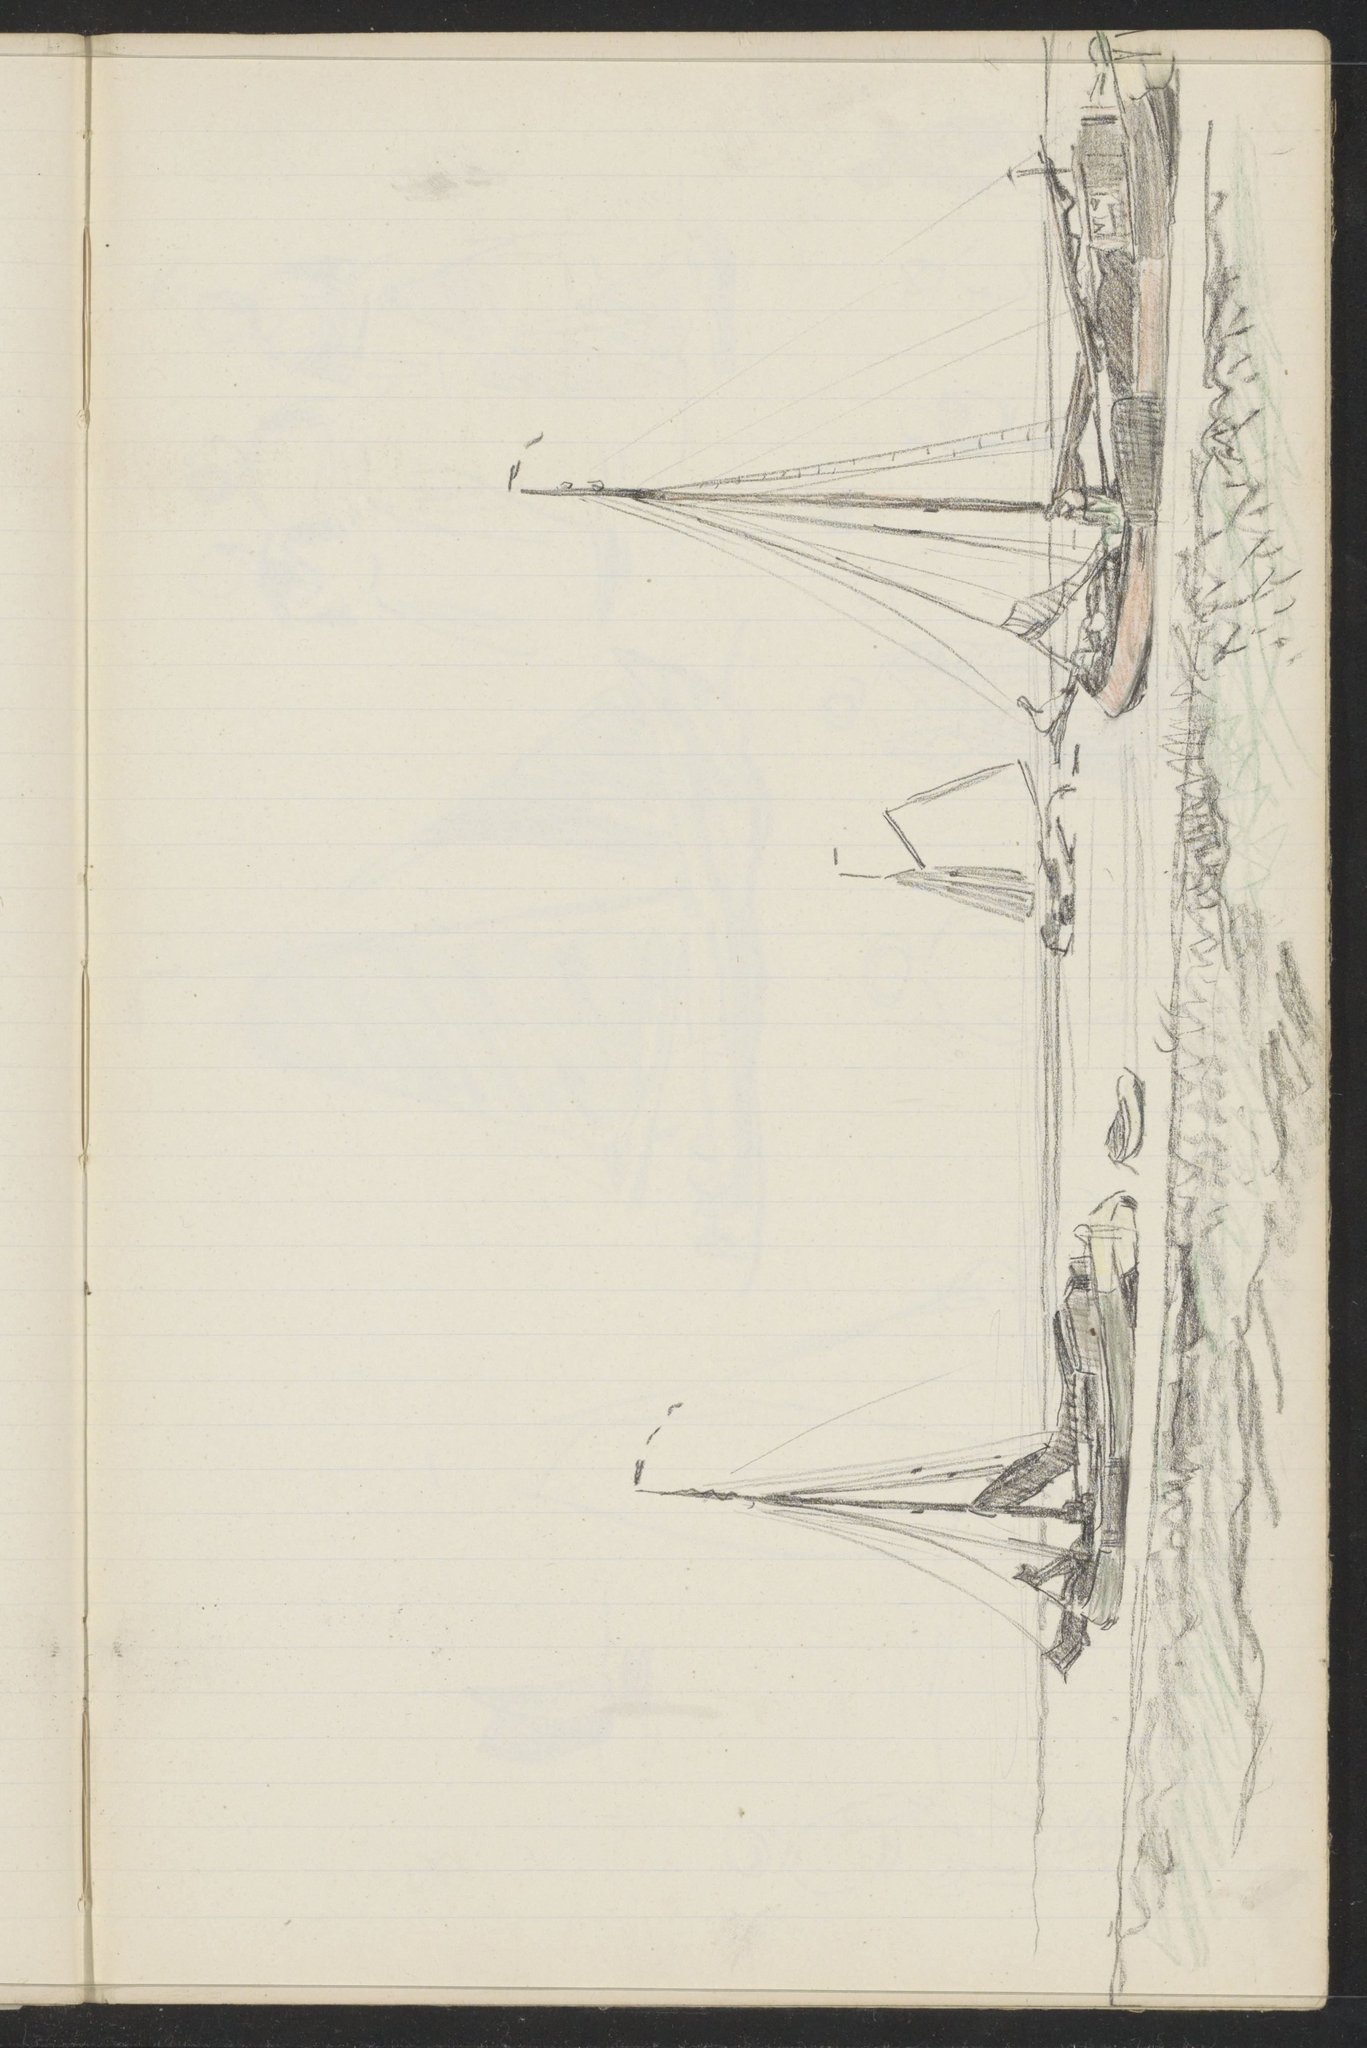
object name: sketchbook leaf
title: Zeilschepen voor anker aan de waterkant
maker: willem bastiaan tholen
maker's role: draughtsman, painter, print maker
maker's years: 1860-1931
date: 1900-1931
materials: chalk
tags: sailing-ship, sailing-boat, landscapes with waters, waterscapes, seascapes (in the temperate zone)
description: Blad 52 recto uit een schetsboek met 55 bladen.